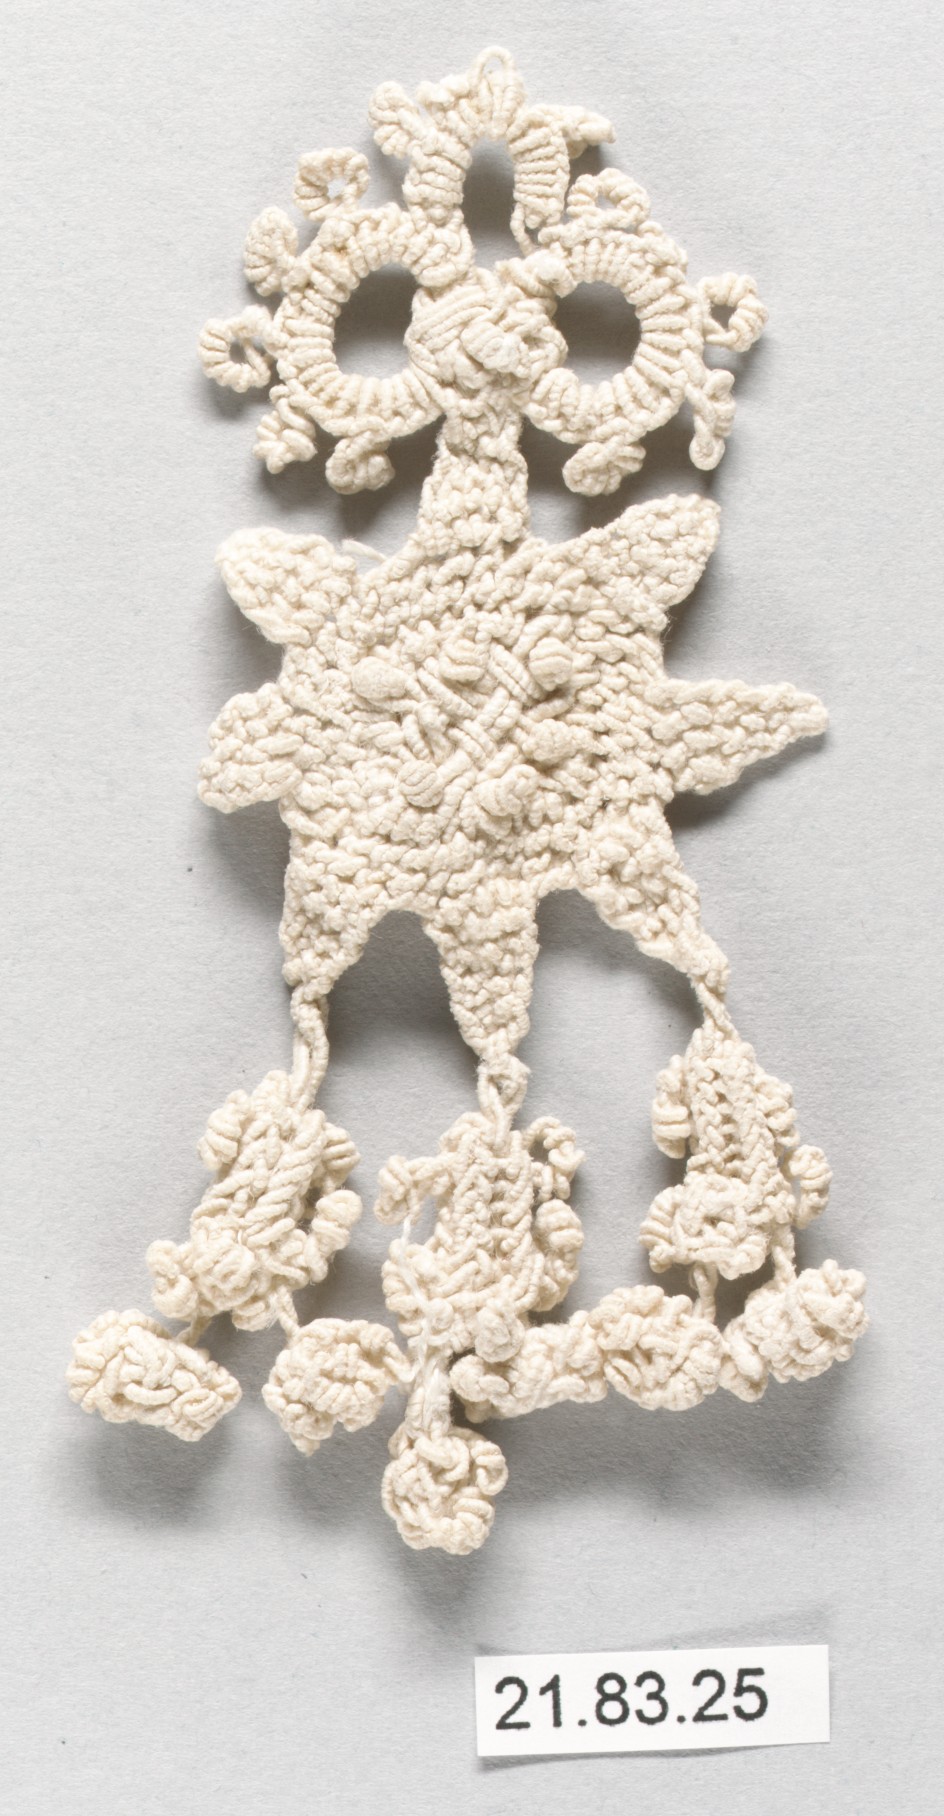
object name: tassel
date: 1601-1700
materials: linen